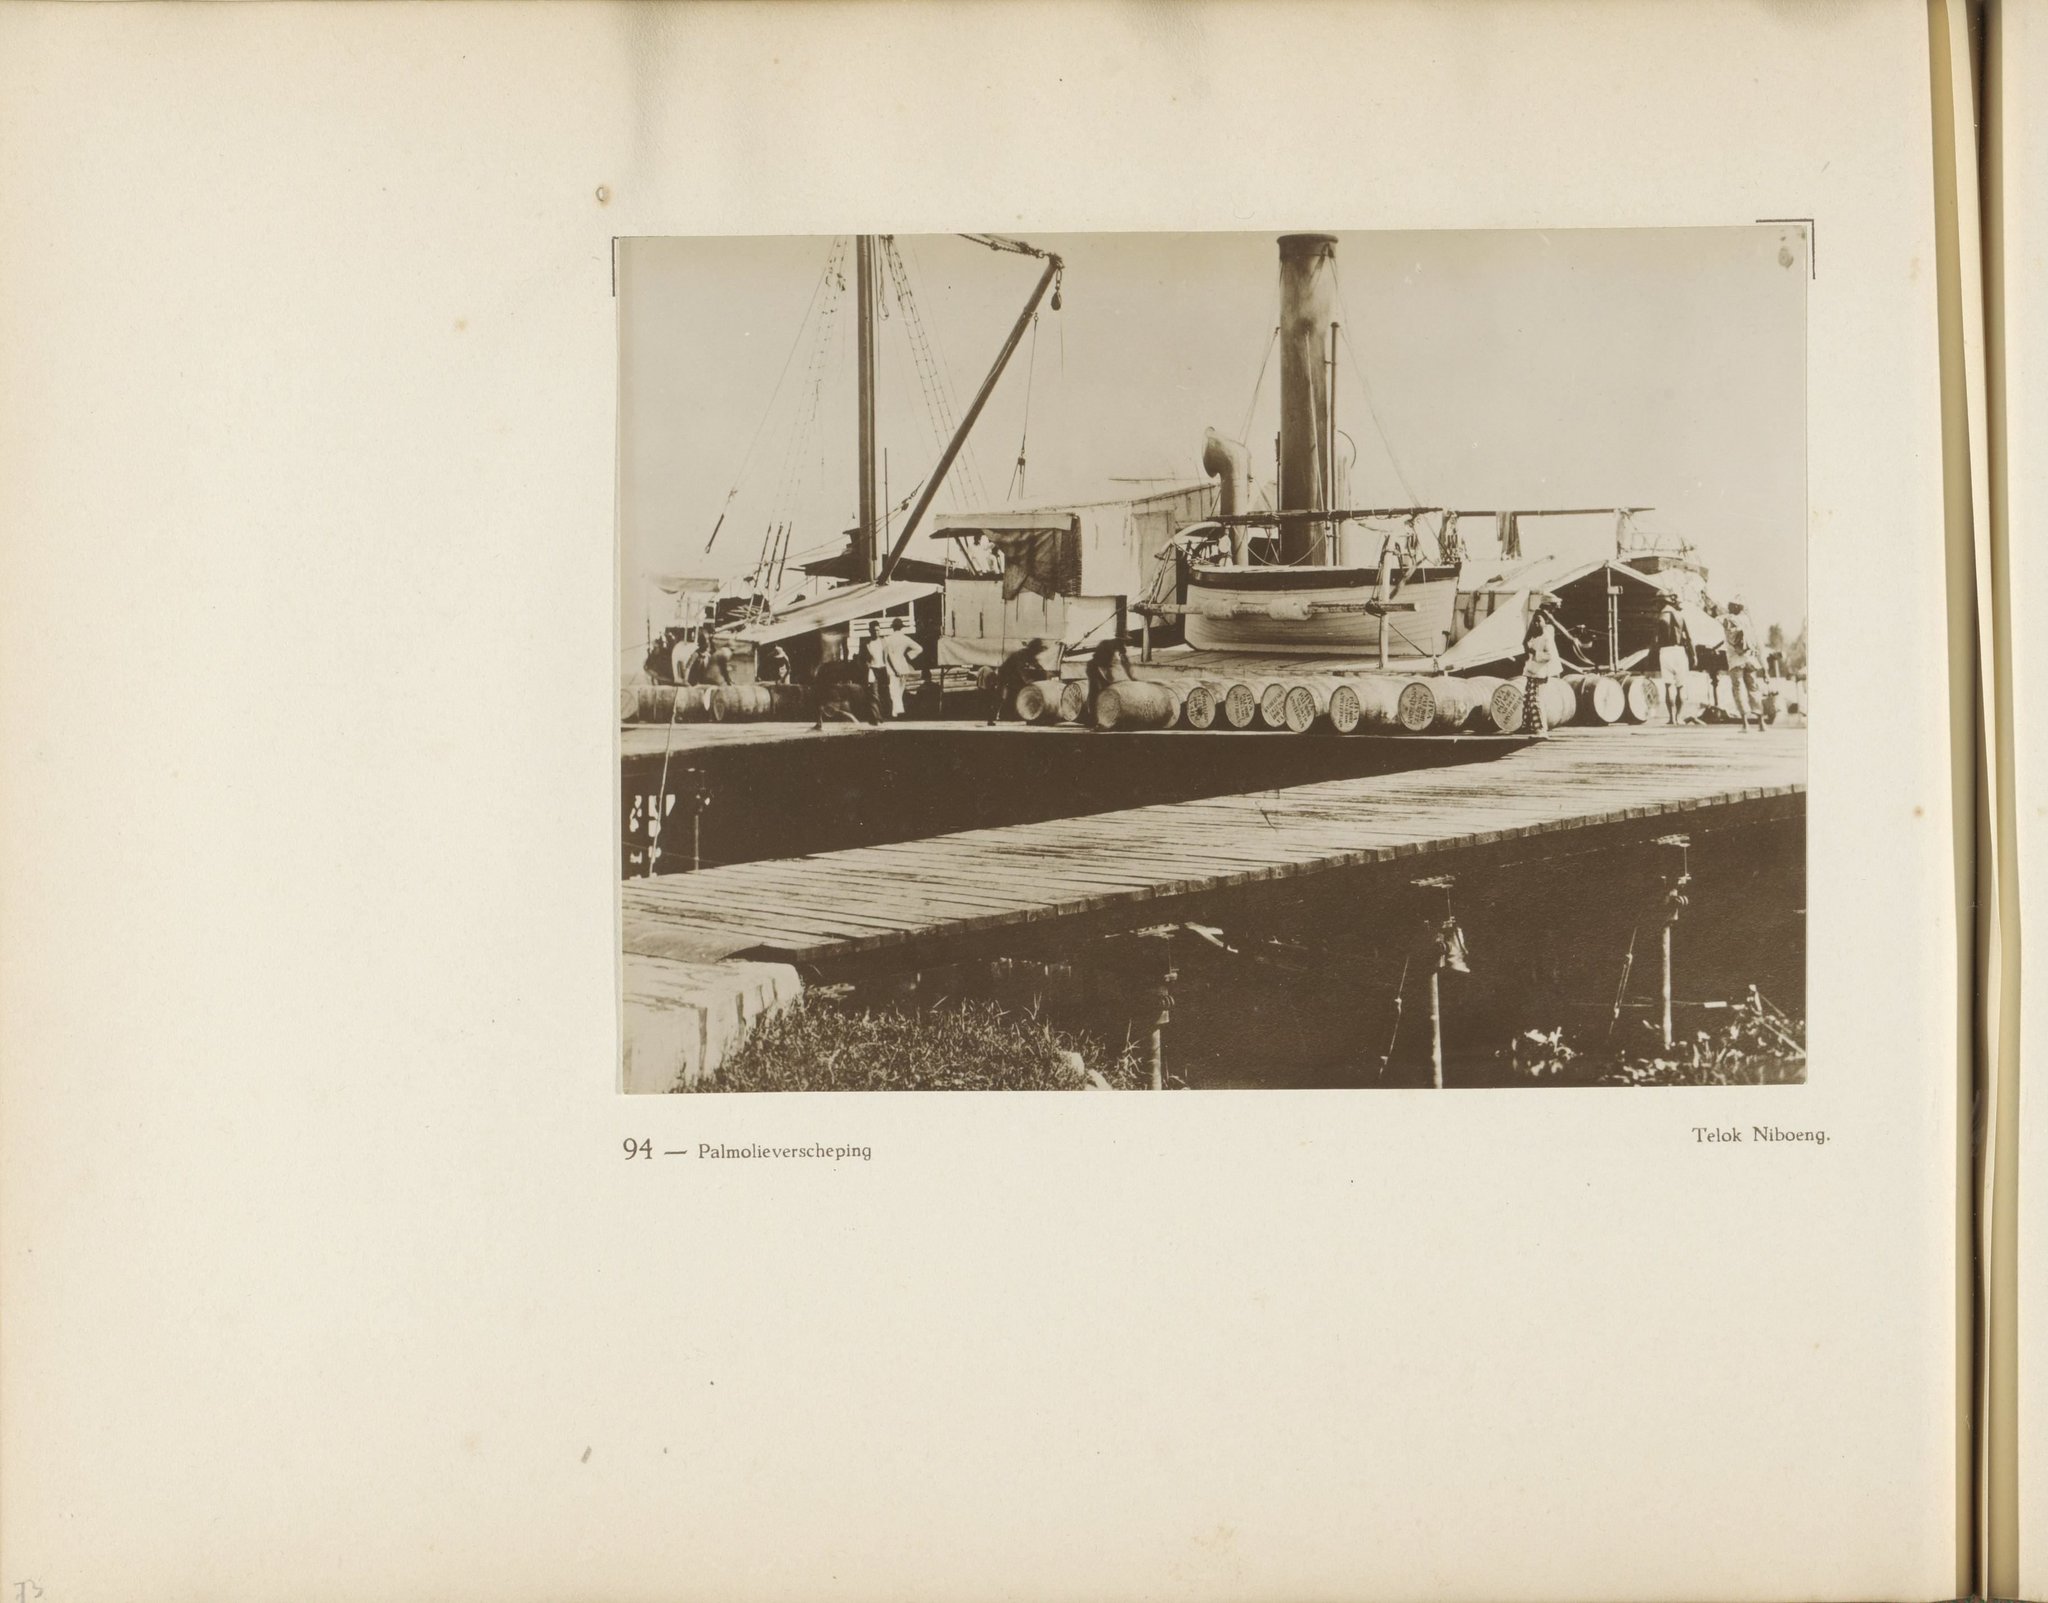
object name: photograph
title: Pagina 94 van fotoboek van de Algemeene Vereeniging van Rubberplanters ter Oostkust van Sumatra (A.V.R.O.S.)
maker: j.w. meyster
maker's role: fotograaf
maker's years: 1887-1945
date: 1924-1925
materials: paper, photographic support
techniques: printing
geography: dutch east indies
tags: wooden container: barrel, cask, bucket, (non-fruit) products of plants or trees: rubber, freight vessel, trees: palm-tree, sumatra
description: Boekpagina met een foto van de verscheping van palmolie te Telok Niboeng nadat deze in een fabriek voor palmoliebereiding is gewonnen. Onderdeel van een fotoboek van de Algemeene Vereeniging van Rubberplanters ter Oostkust van Sumatra (A.V.R.O.S.).